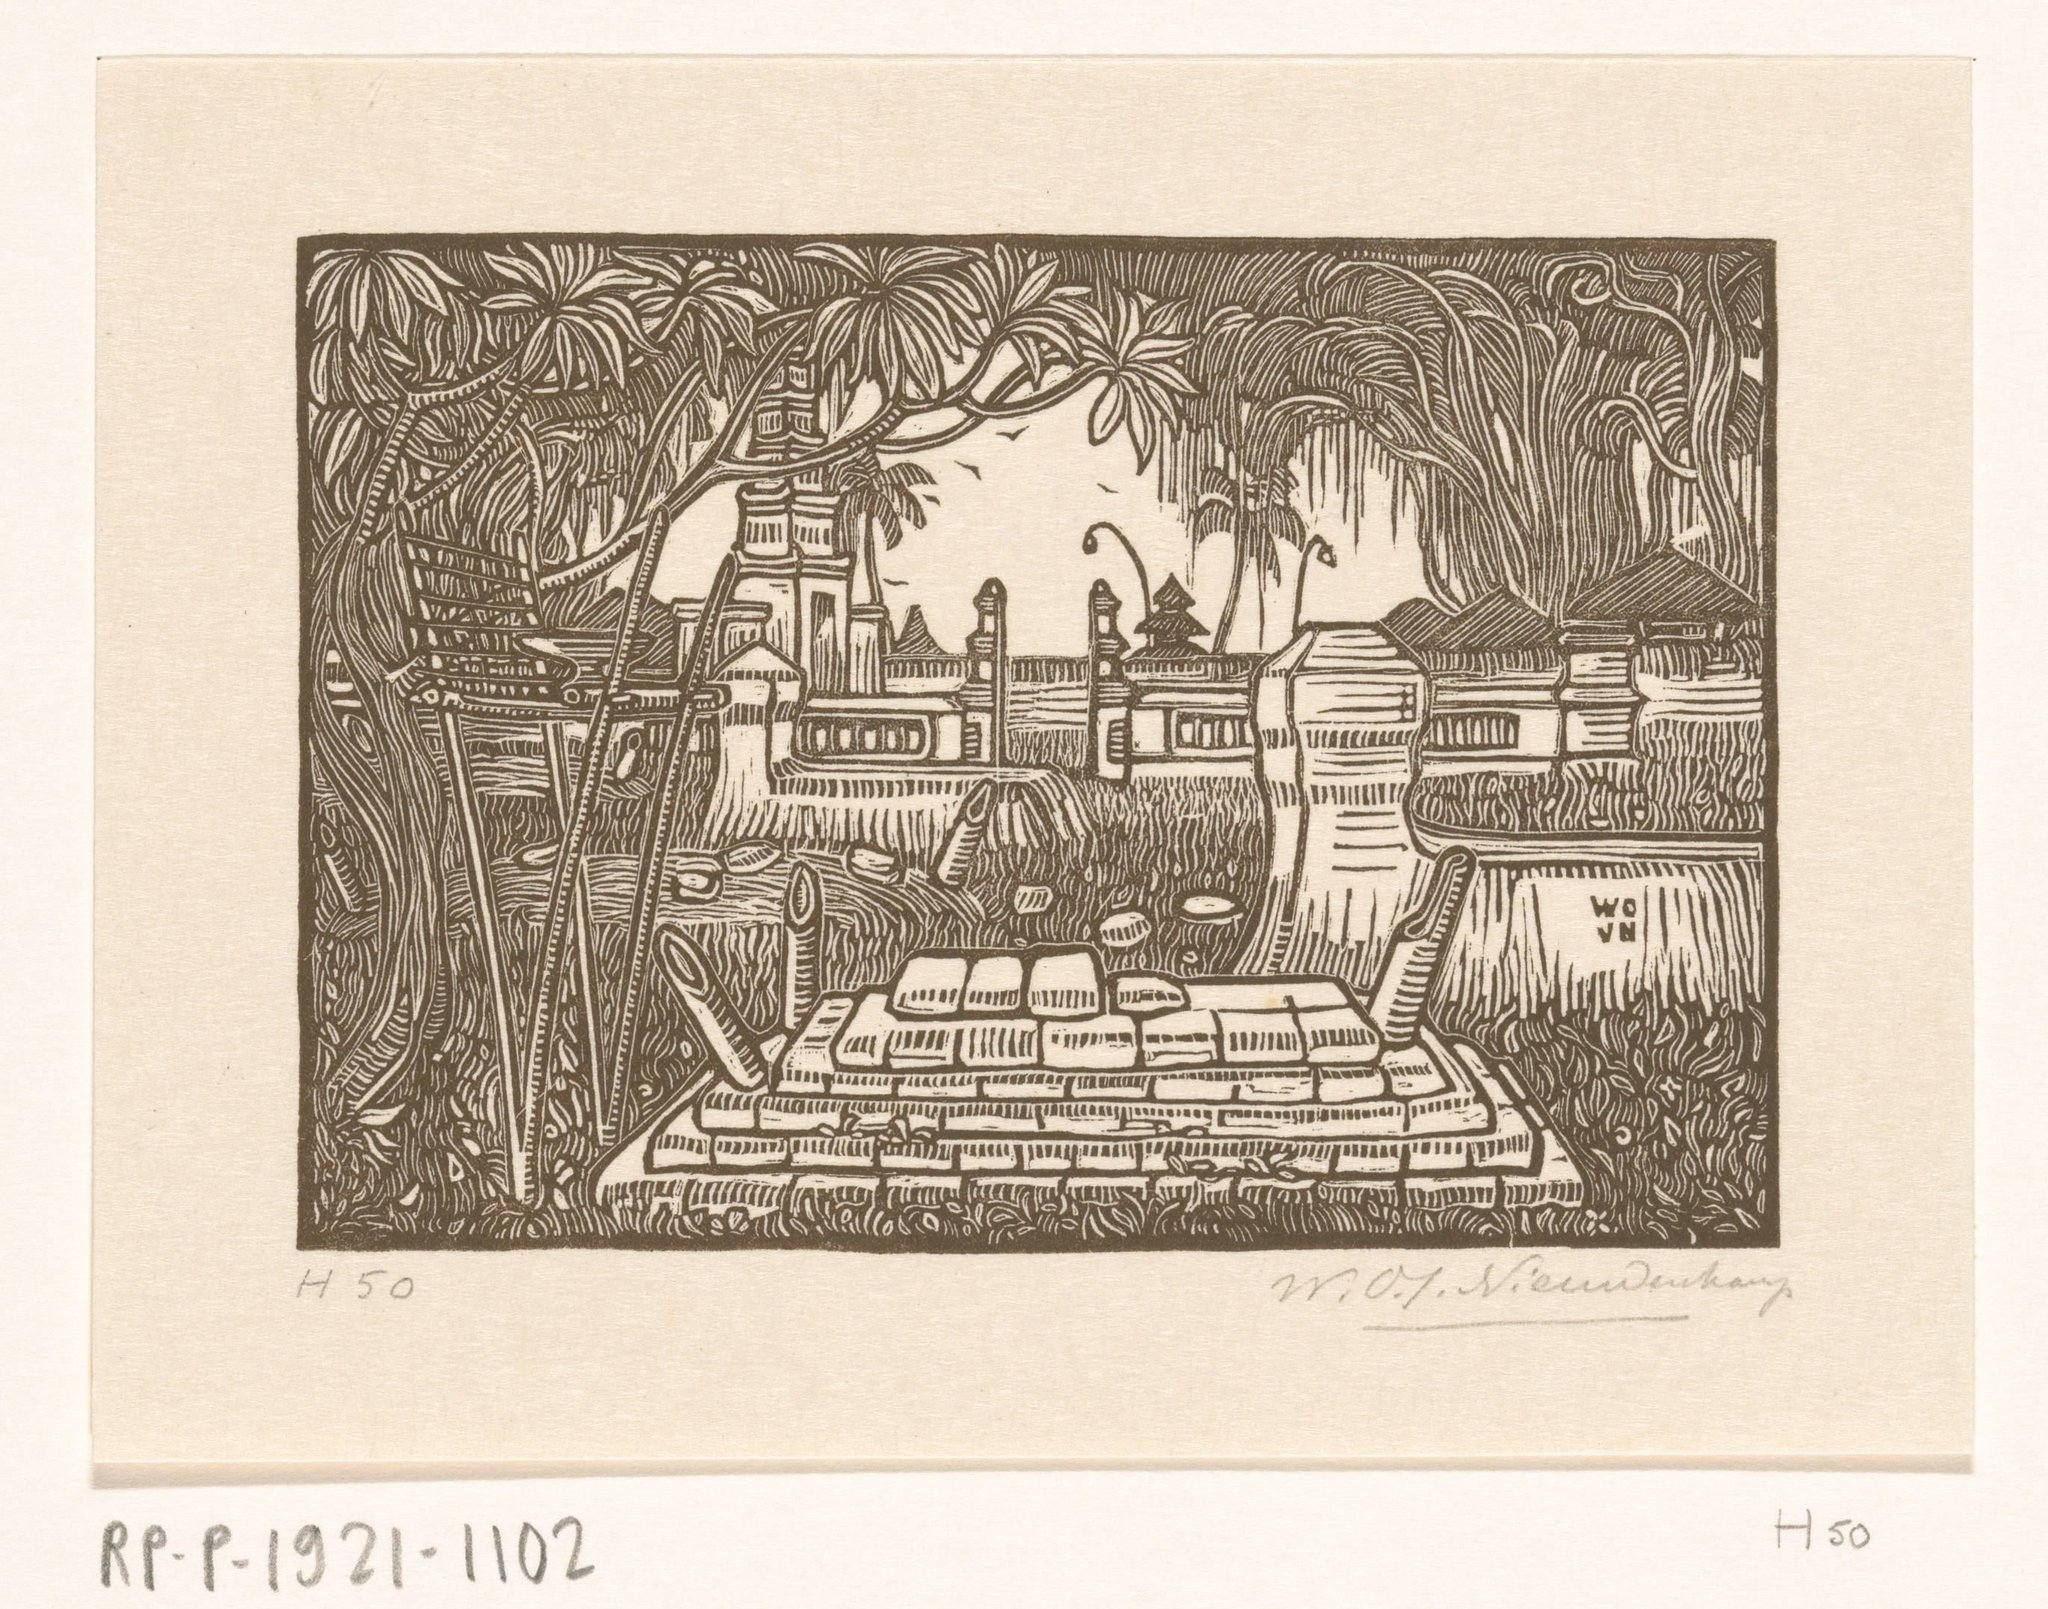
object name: print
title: Begraafplaats bij Singaraja op Bali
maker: wijnand otto jan nieuwenkamp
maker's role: draughtsman, print maker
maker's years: 1874-1950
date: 1904-1908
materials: paper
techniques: woodcut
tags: cemetery, park-like burying ground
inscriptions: collector's mark: Lugt 2233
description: Op de voorgrond graven en planten. Op de achtergrond een tempel.